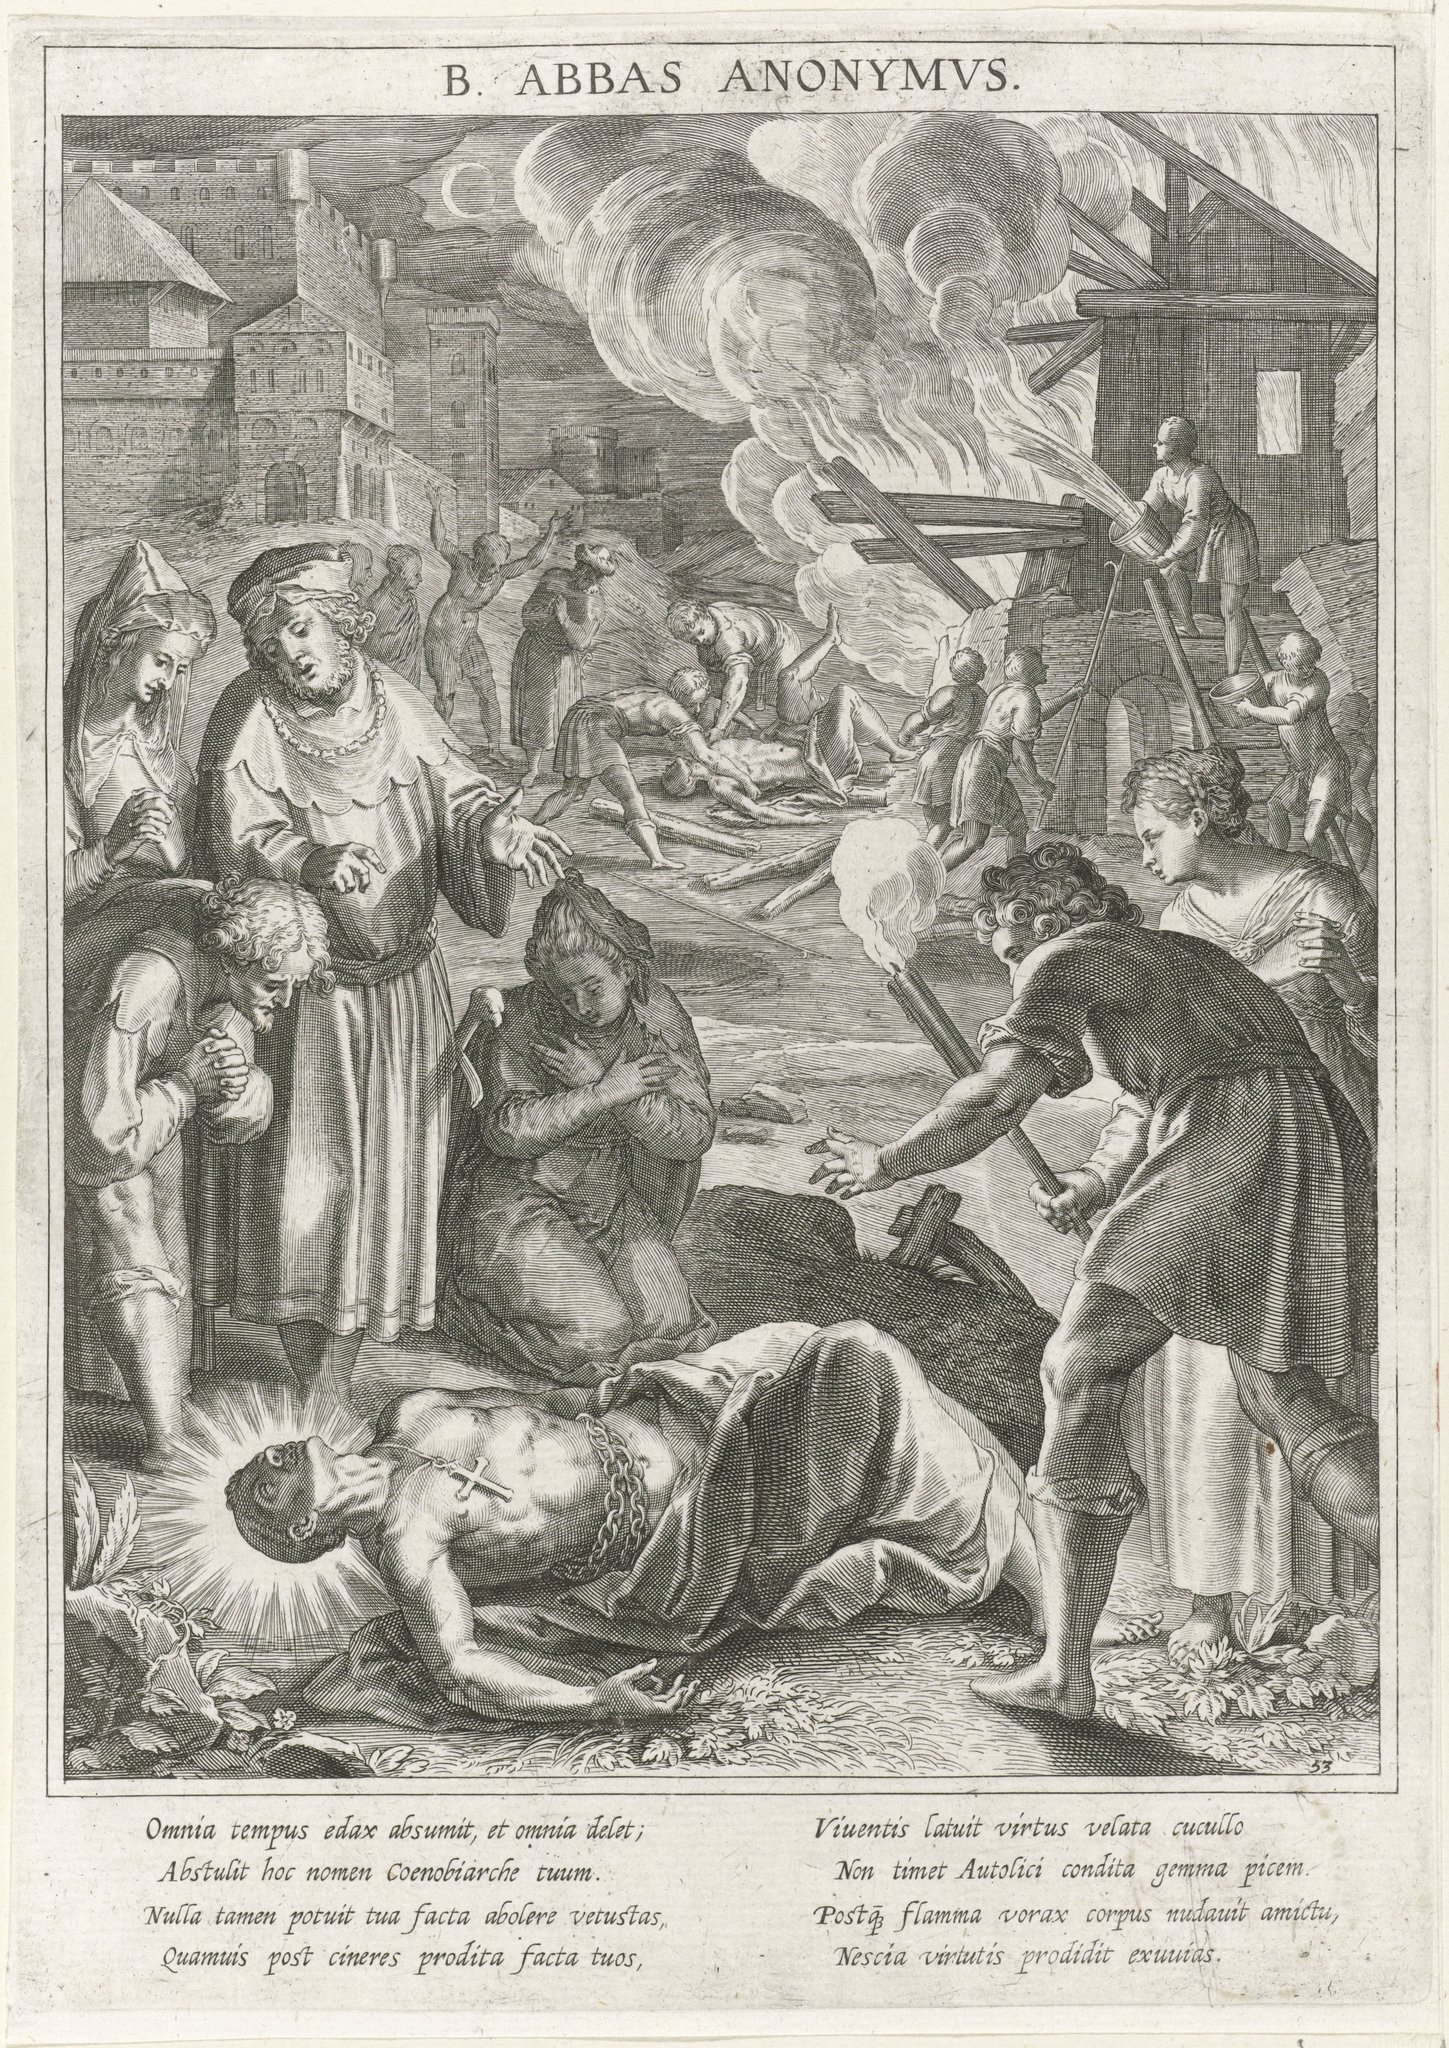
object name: print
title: B. abbas anonymvs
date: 1615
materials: paper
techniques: engraving, etching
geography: munich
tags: extinguishing a fire, accidental death ~ fire, saints, miraculous healing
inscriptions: collector's mark: Lugt 240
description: Op de voorgrond wordt het intacte lijk van een anonieme abt die stierf in een brandend huis door het volk getoond aan de hertog van Beieren. Op de achtergrond wordt het huis waar de abt stierf geblust. De prent heeft een Latijns onderschrift en is de 53ste prent van een 60-delige serie met als onderwerp de heiligen van Beieren.